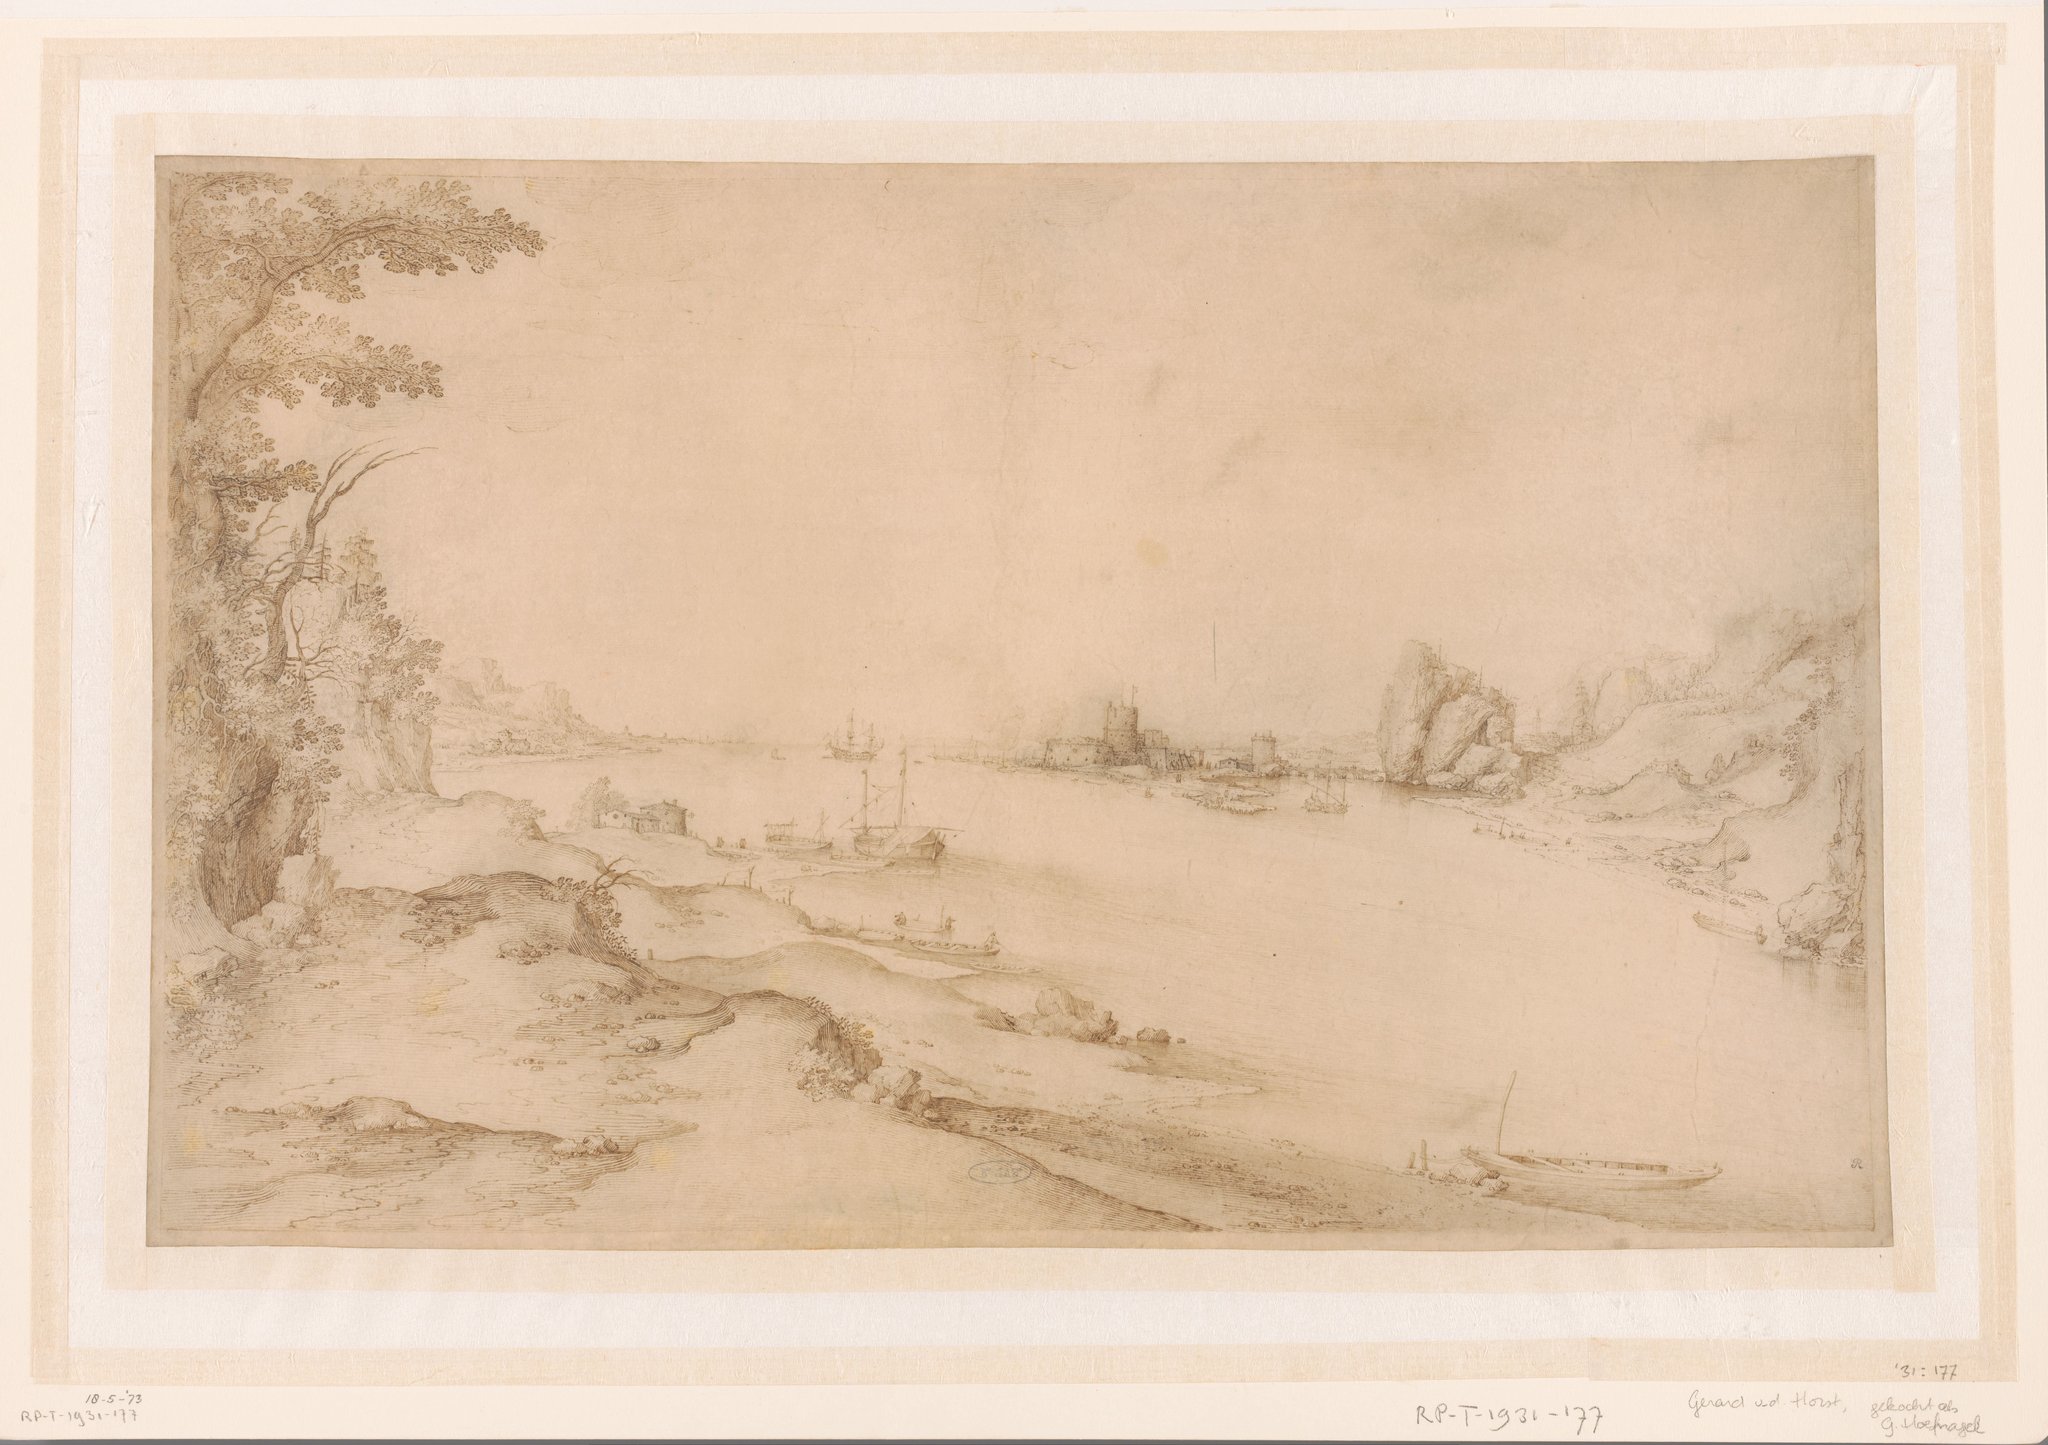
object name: drawing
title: Riviermond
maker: gerard van der horst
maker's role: draughtsman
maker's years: 1581-1629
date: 1610-1628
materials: ink, parchment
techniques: pen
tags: harbour, fortress, river mouth, estuary